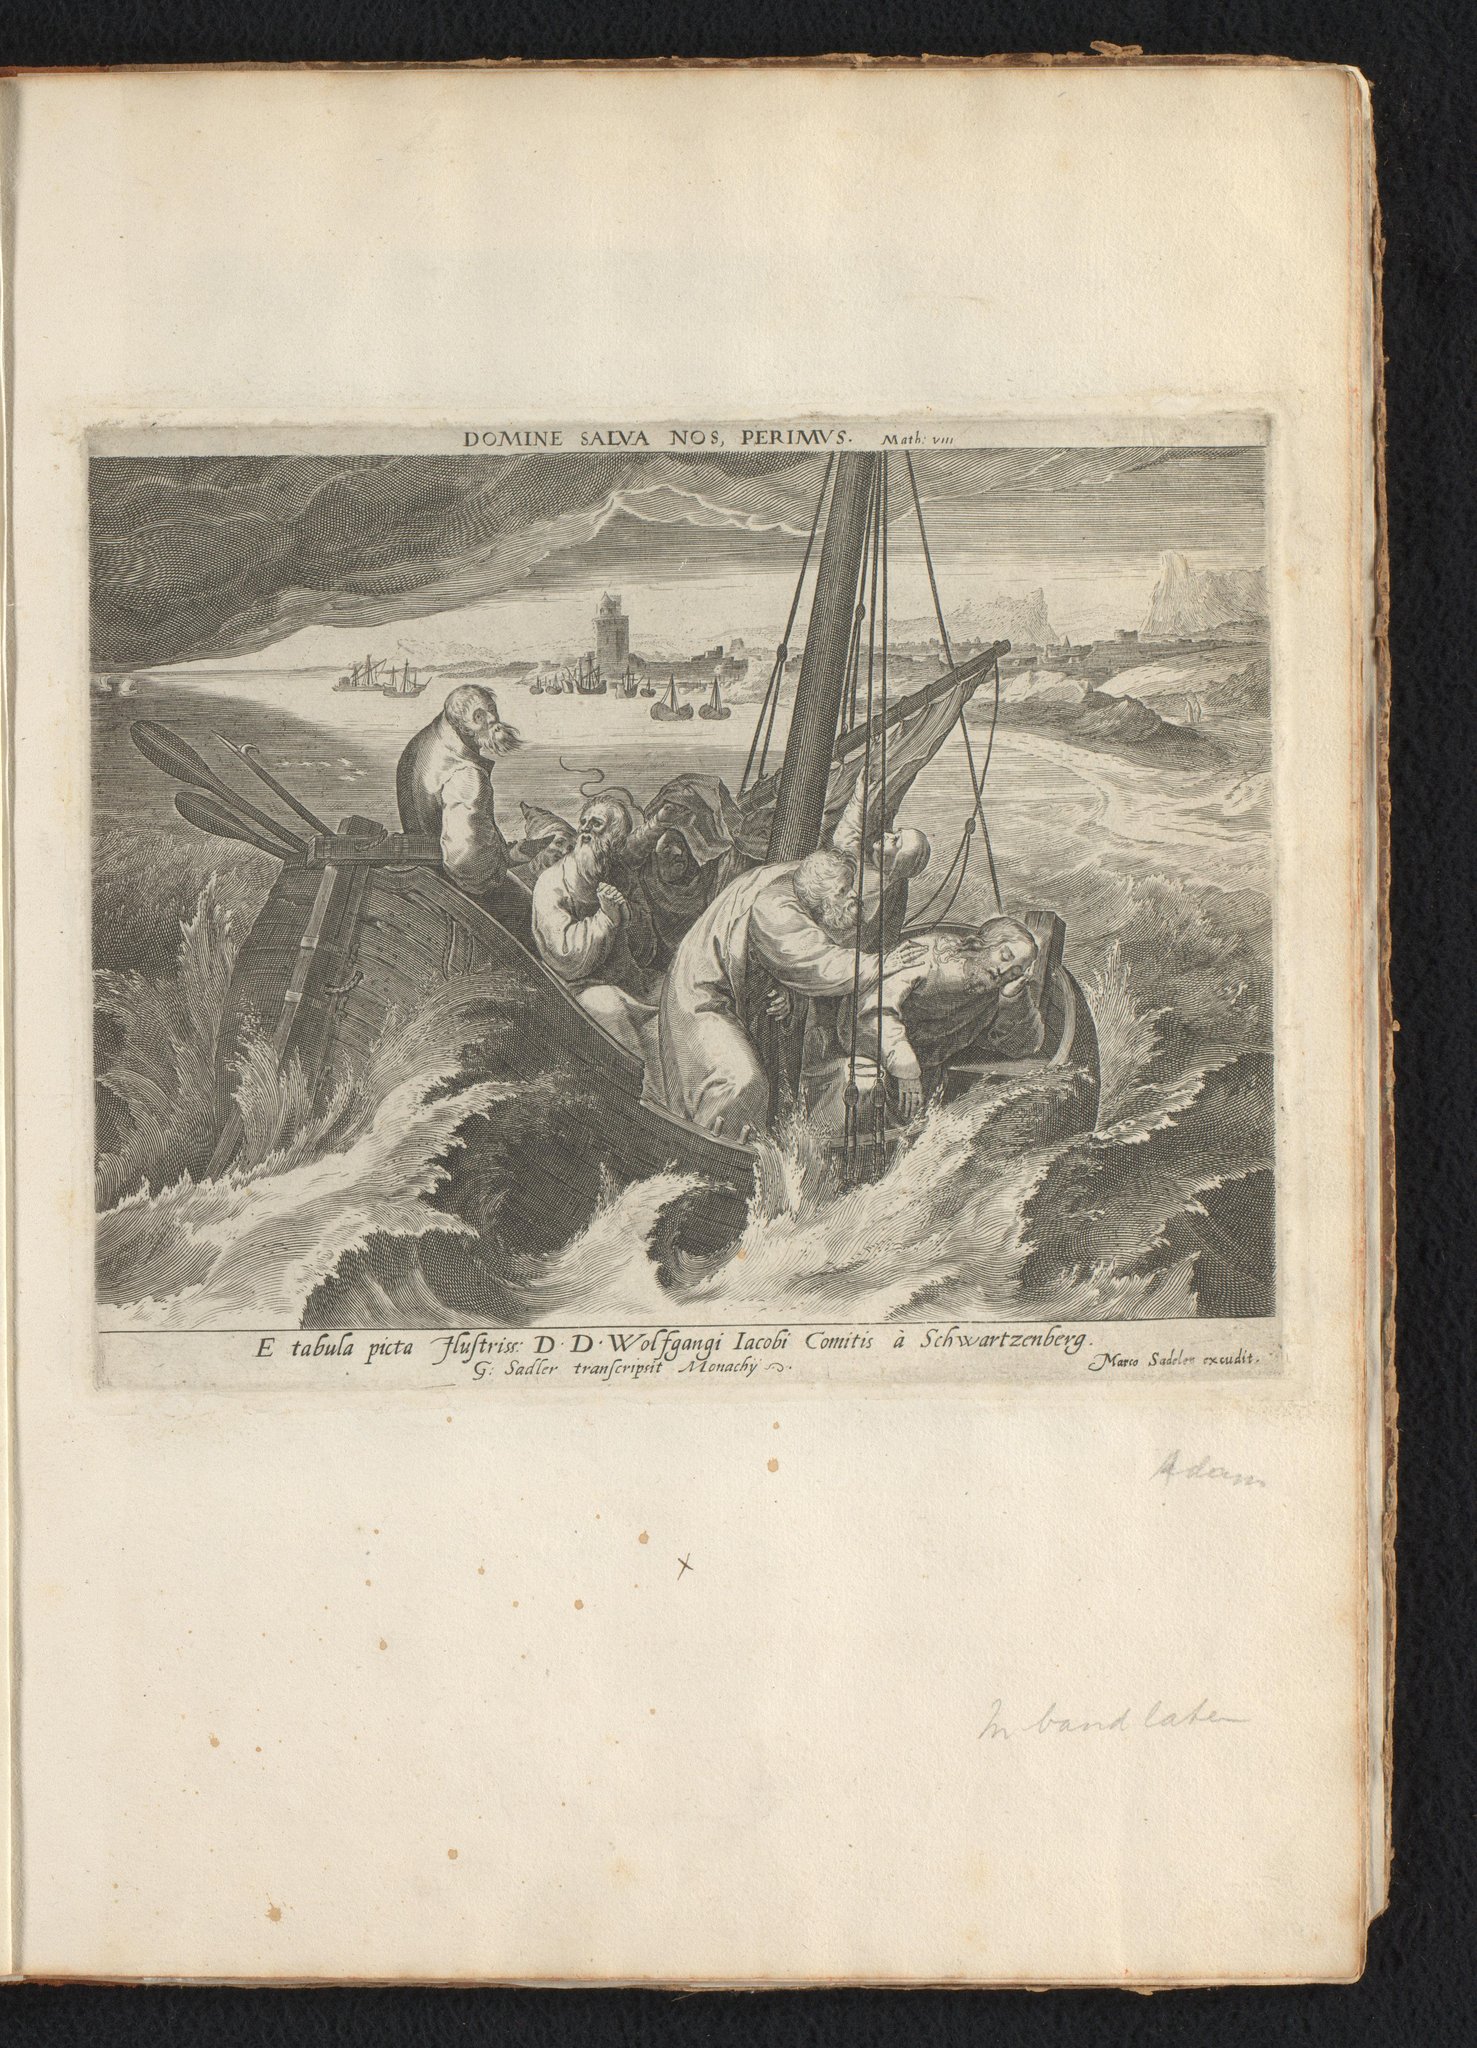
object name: album leaf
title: Domine salva nos, perimus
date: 1594-1597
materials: paper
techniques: engraving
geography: munich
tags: christ in a boat with the apostles, talking or sleeping, the apostles awake christ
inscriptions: title: ‘DOMINE SALVA NOS, PERIMUS. Math. VIII’, signature: ‘G:Sadler transcripsit Monachij’, address: ‘Marco Sadeler excudit.’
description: Christus en zes van zijn leerlingen varen in een vissersboot op het meer van Galilea, terwijl het stormt. Christus ligt te slapen en Petrus probeert hem te wekken. Op de achtergrond de kust. Deze prent maakt deel uit van een album.